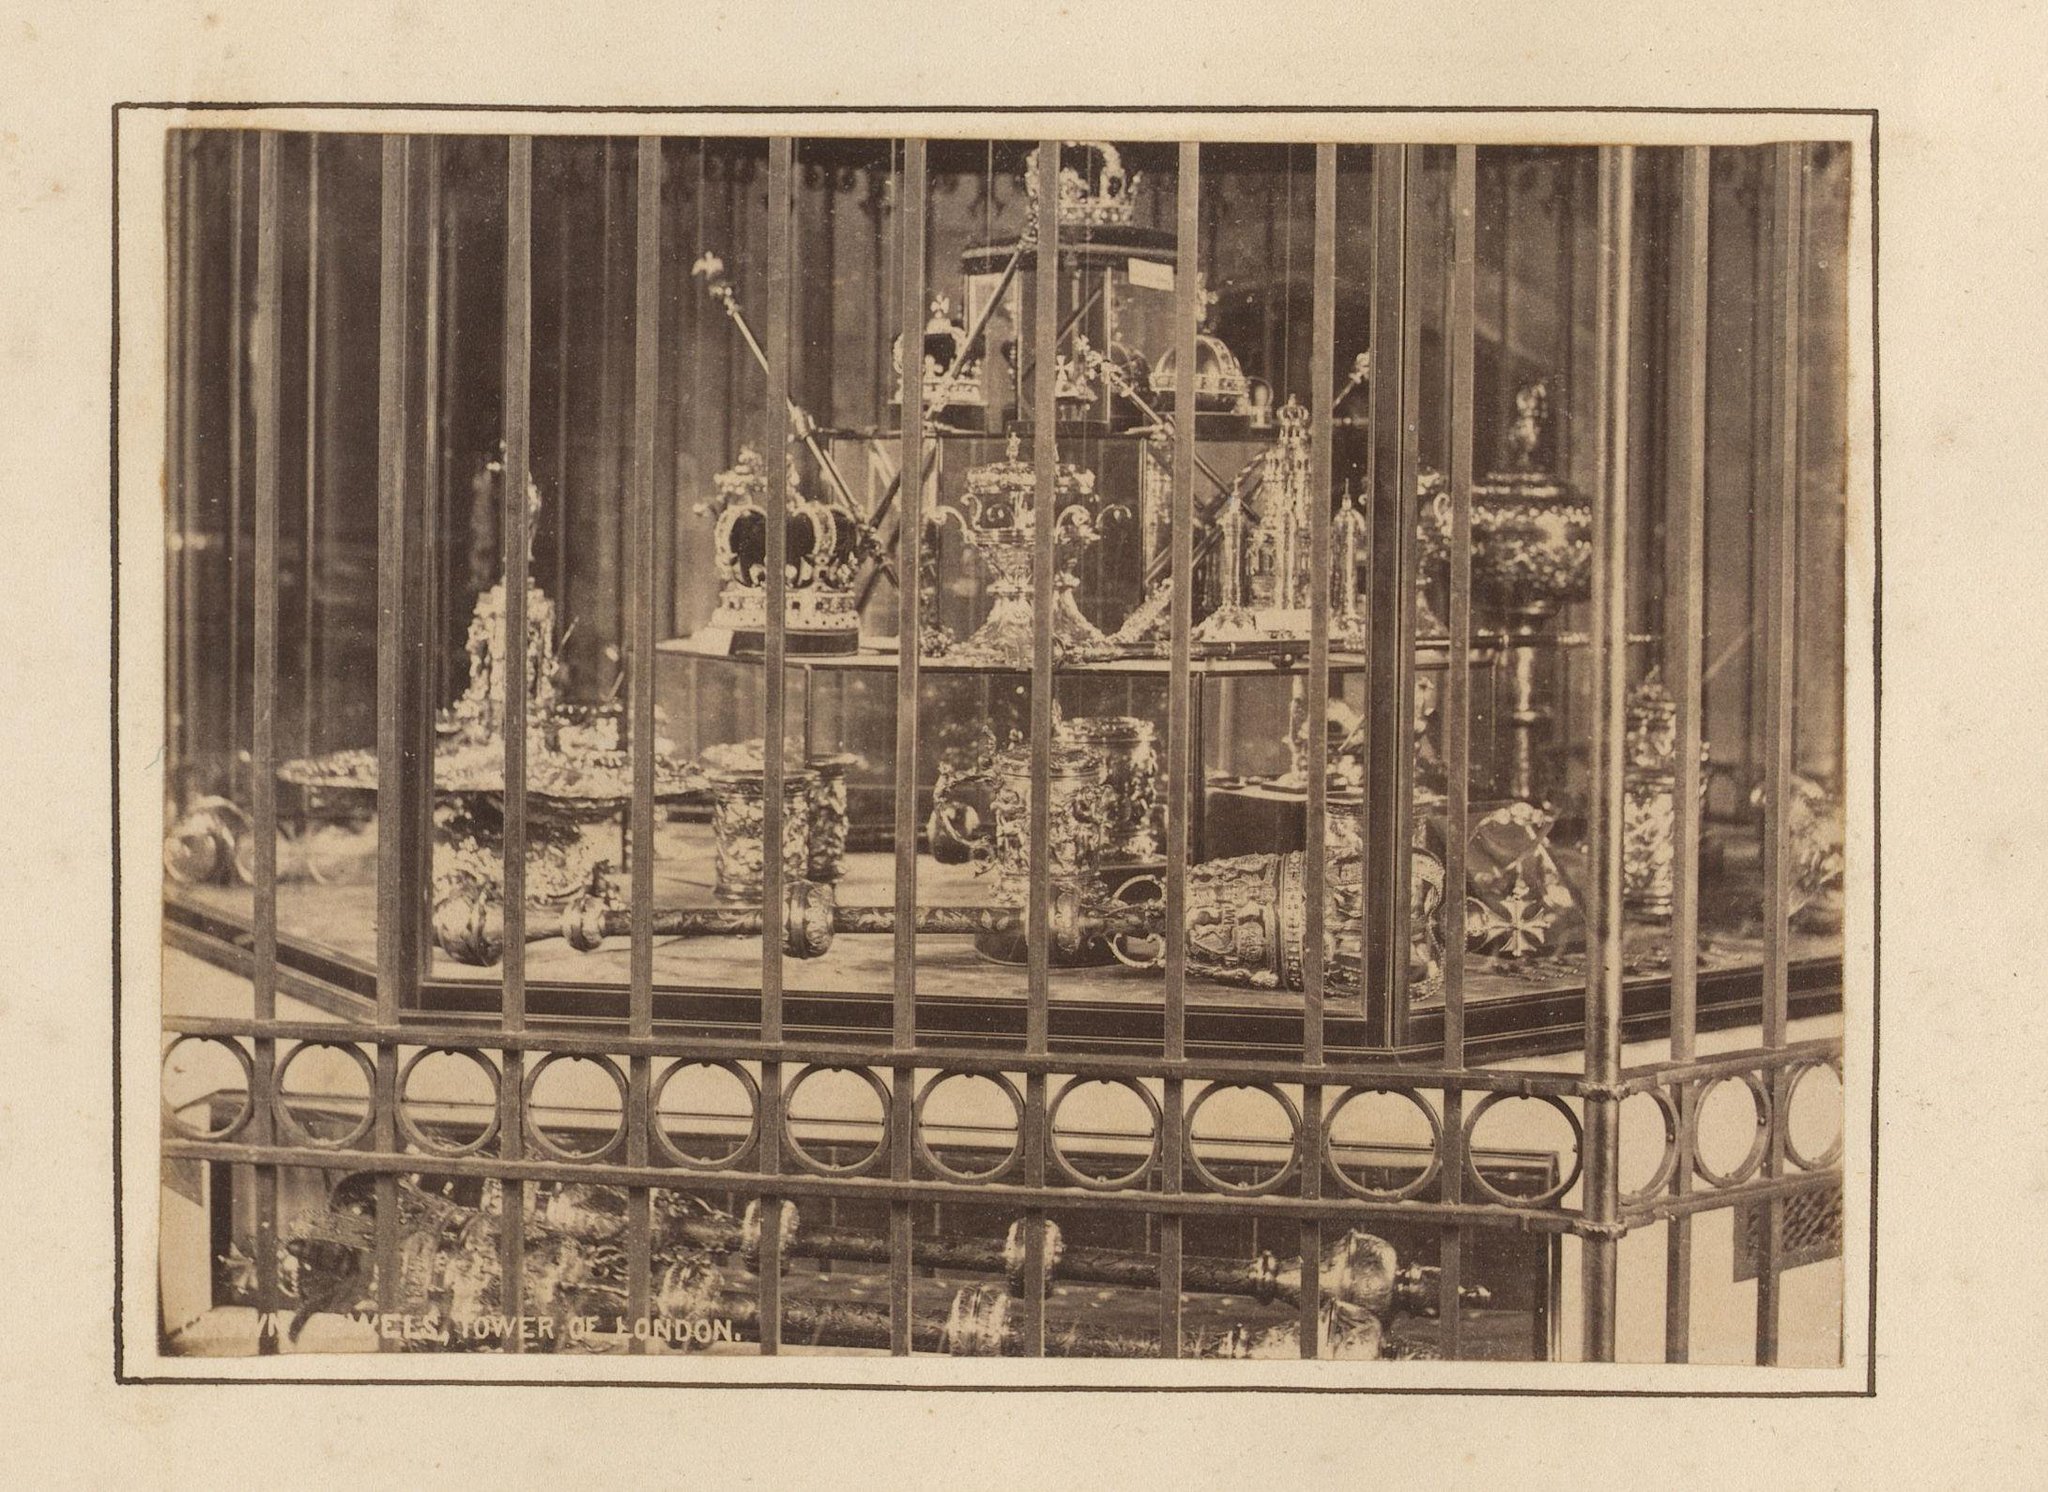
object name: photograph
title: Crown-Jewels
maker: Anonymous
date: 1870-1890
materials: paper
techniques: albumen print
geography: tower of london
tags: crown (symbol of sovereignty)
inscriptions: inscription: ‘Crown Jewels, Tower of London.’